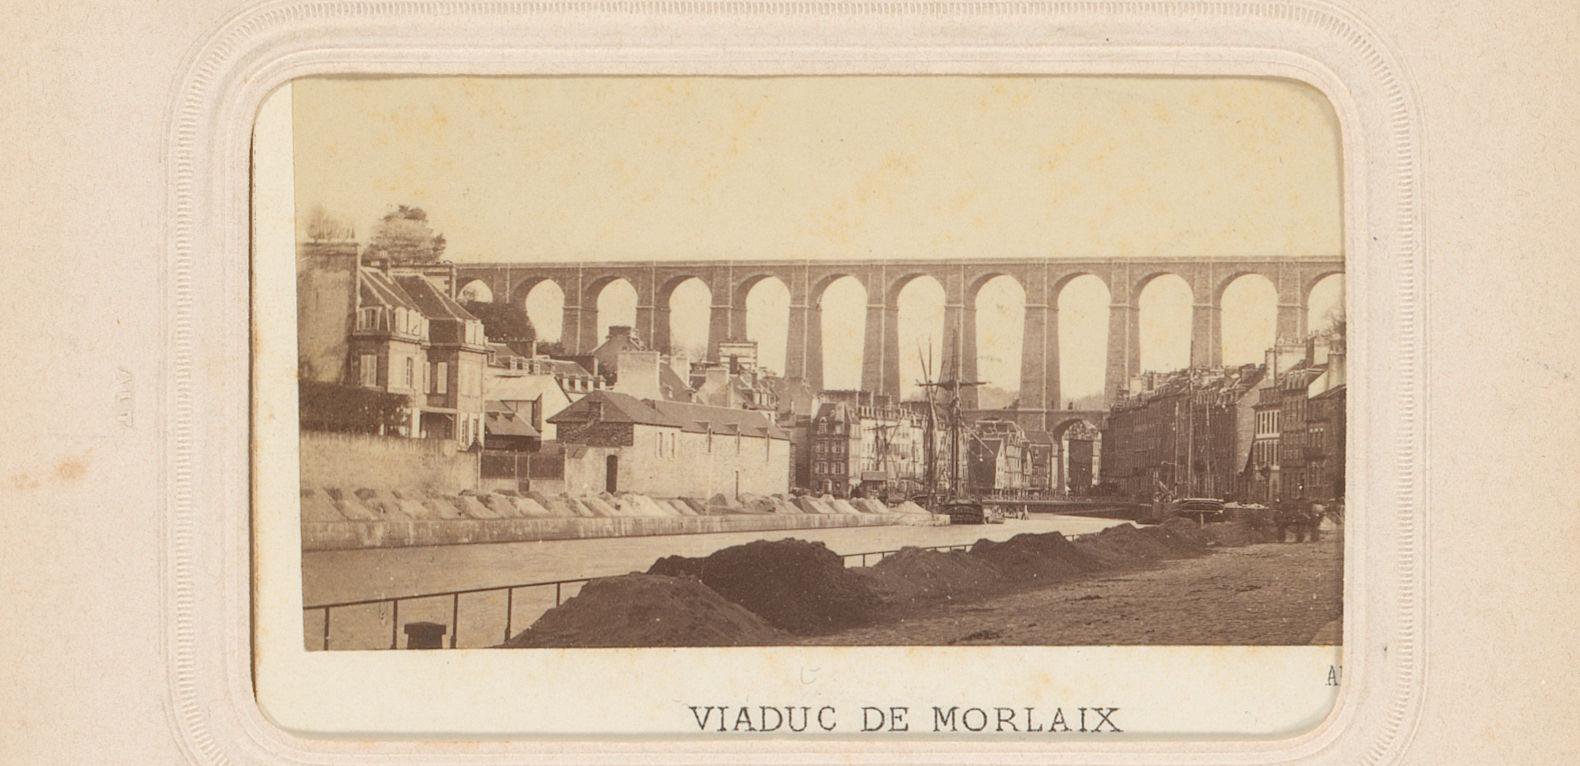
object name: album leaf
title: Viaduc de Morlaix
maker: alfred beau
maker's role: ceramicist, painter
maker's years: 1829-1907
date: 1860-1900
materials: cardboard, photographic support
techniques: albumen print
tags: viaduct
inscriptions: inscription: ‘Alf. Beau Phot.’